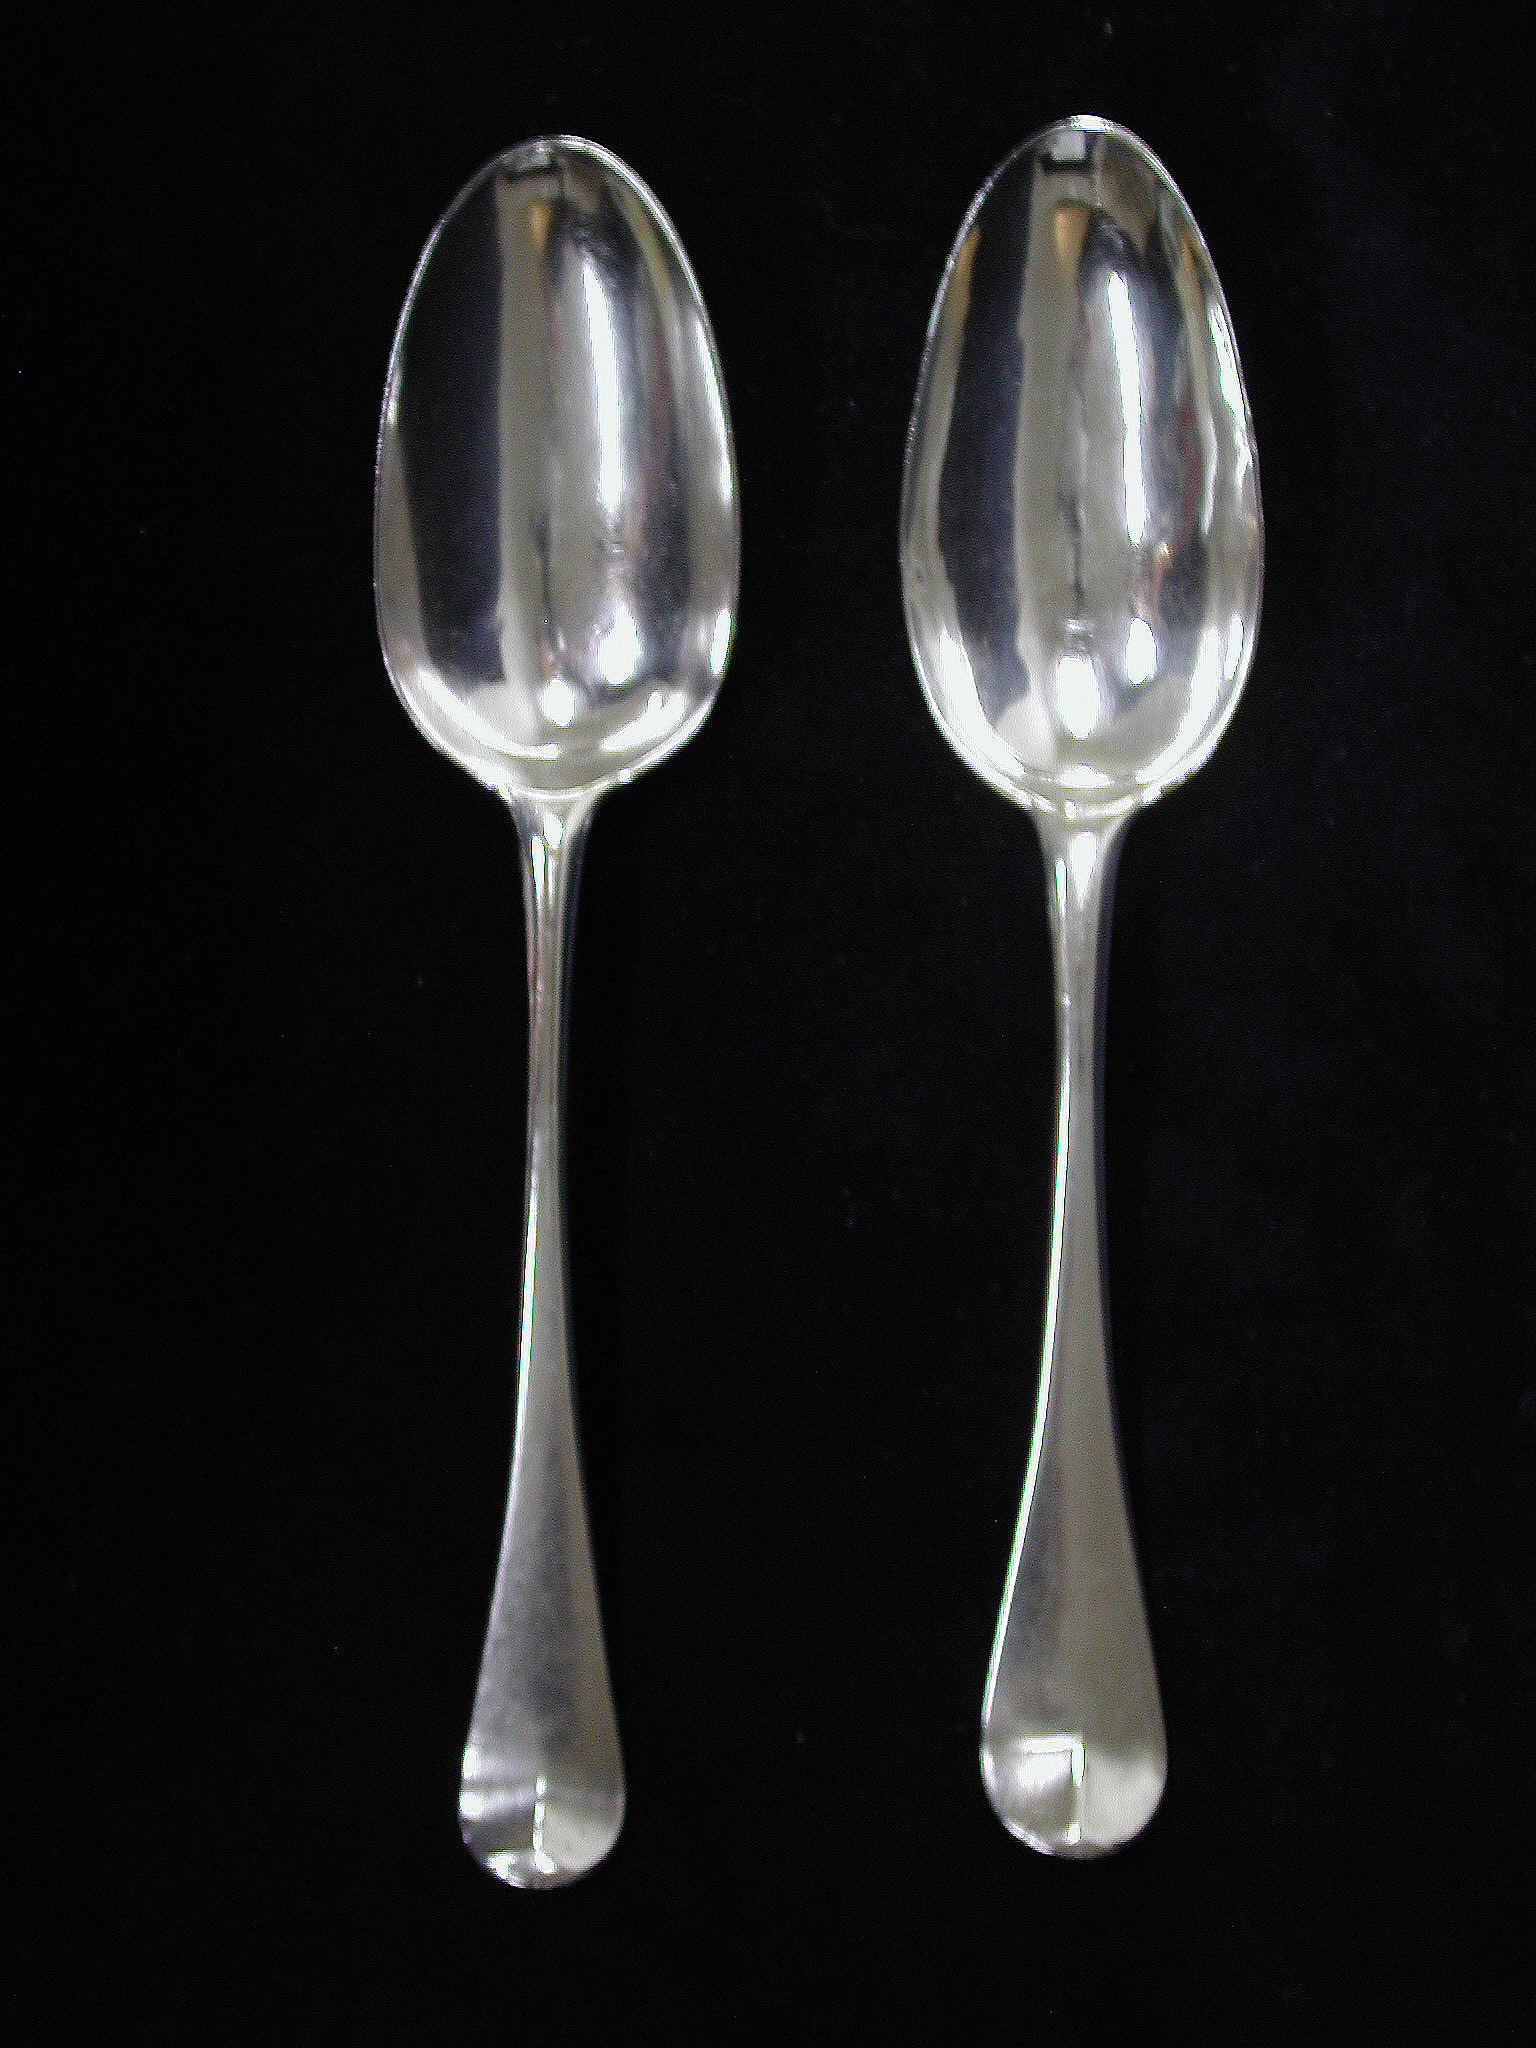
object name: spoon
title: Two spoons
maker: william tant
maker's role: maker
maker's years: 1762-1767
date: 1766-1767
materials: silver